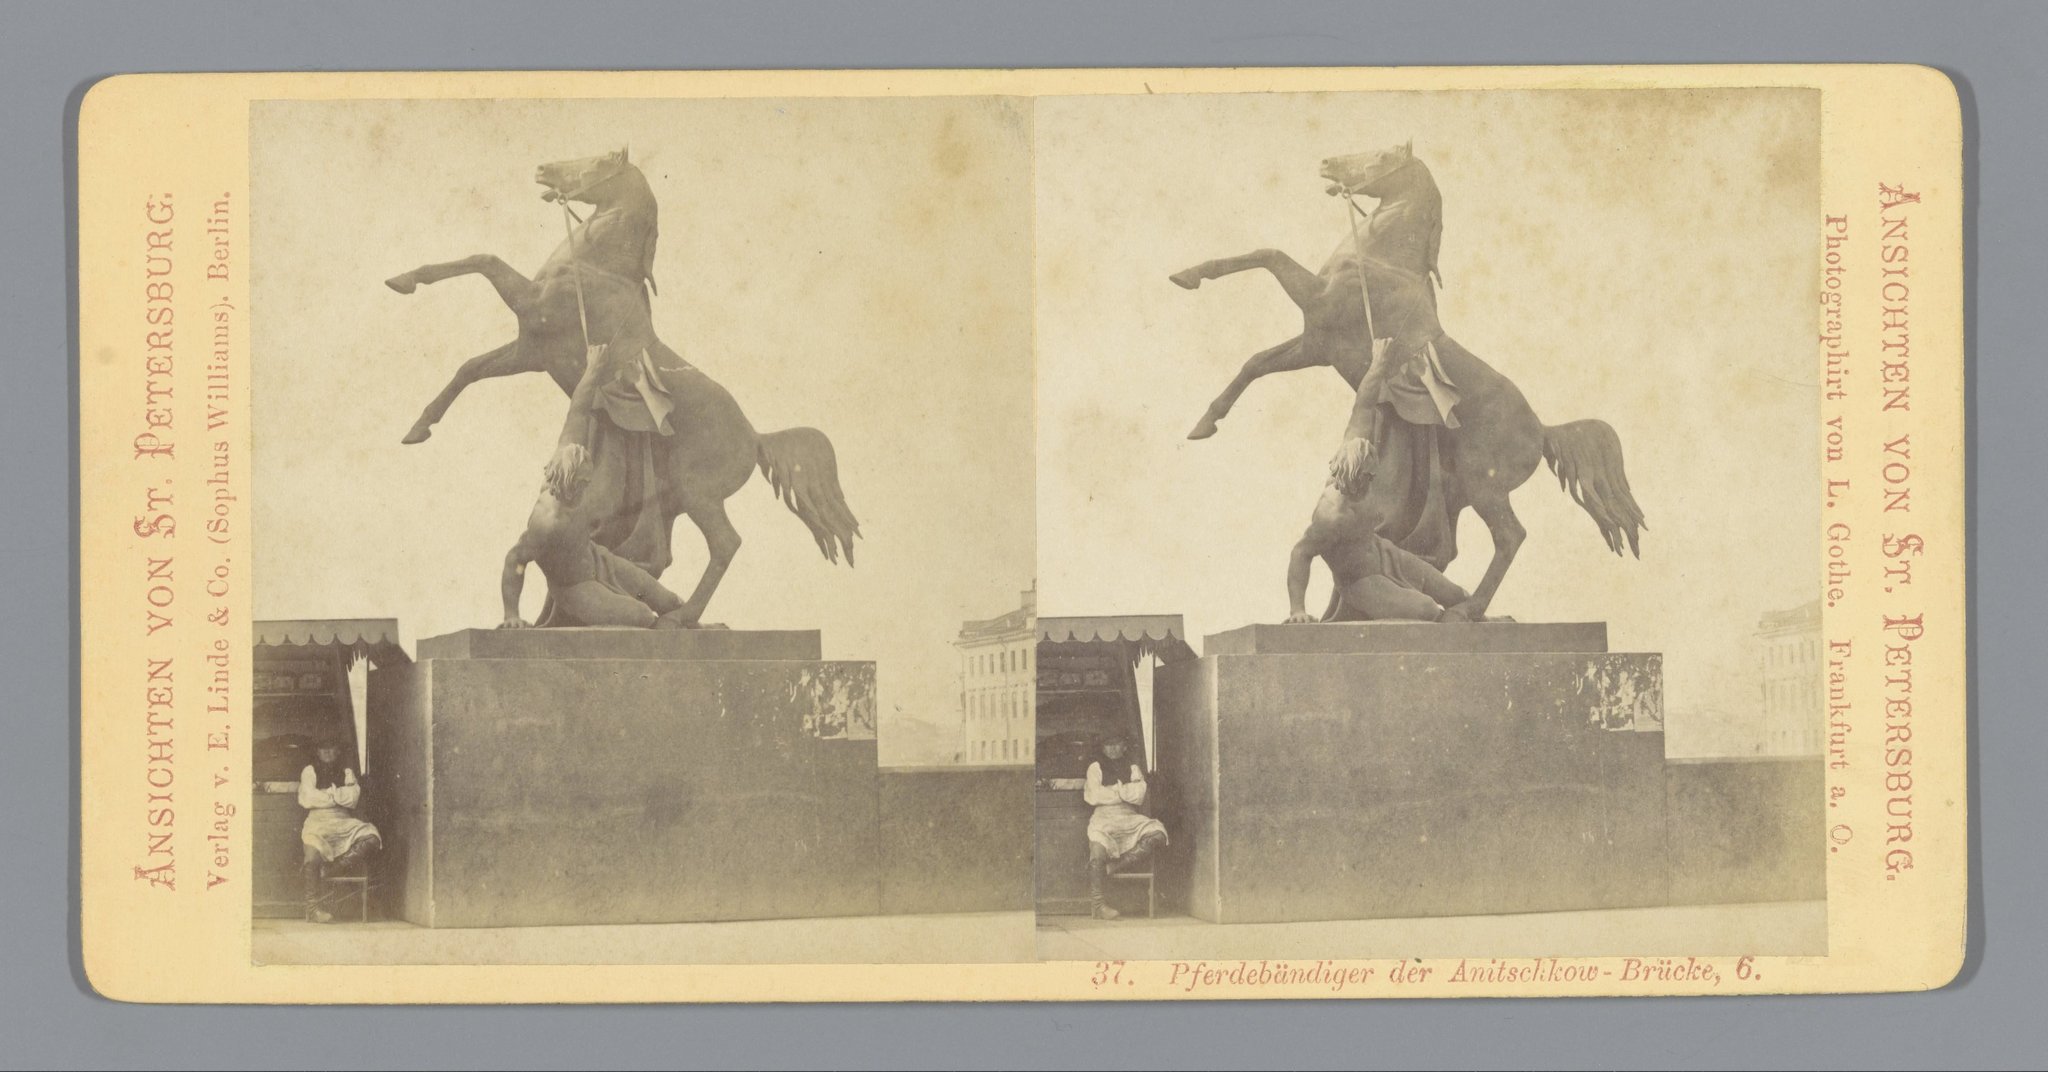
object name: stereograph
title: Sculptuur van een paardentemmer op Anichkovbrug in Sint-Petersburg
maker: louis gothe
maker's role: fotograaf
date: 1850-1880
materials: cardboard, photographic support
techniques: albumen print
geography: sint-petersburg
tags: piece of sculpture, reproduction of a piece of sculpture, bridge in city across river, canal, etc.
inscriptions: inscription: ‘Ansichten von St. Petersburg.’, number: ‘37.’